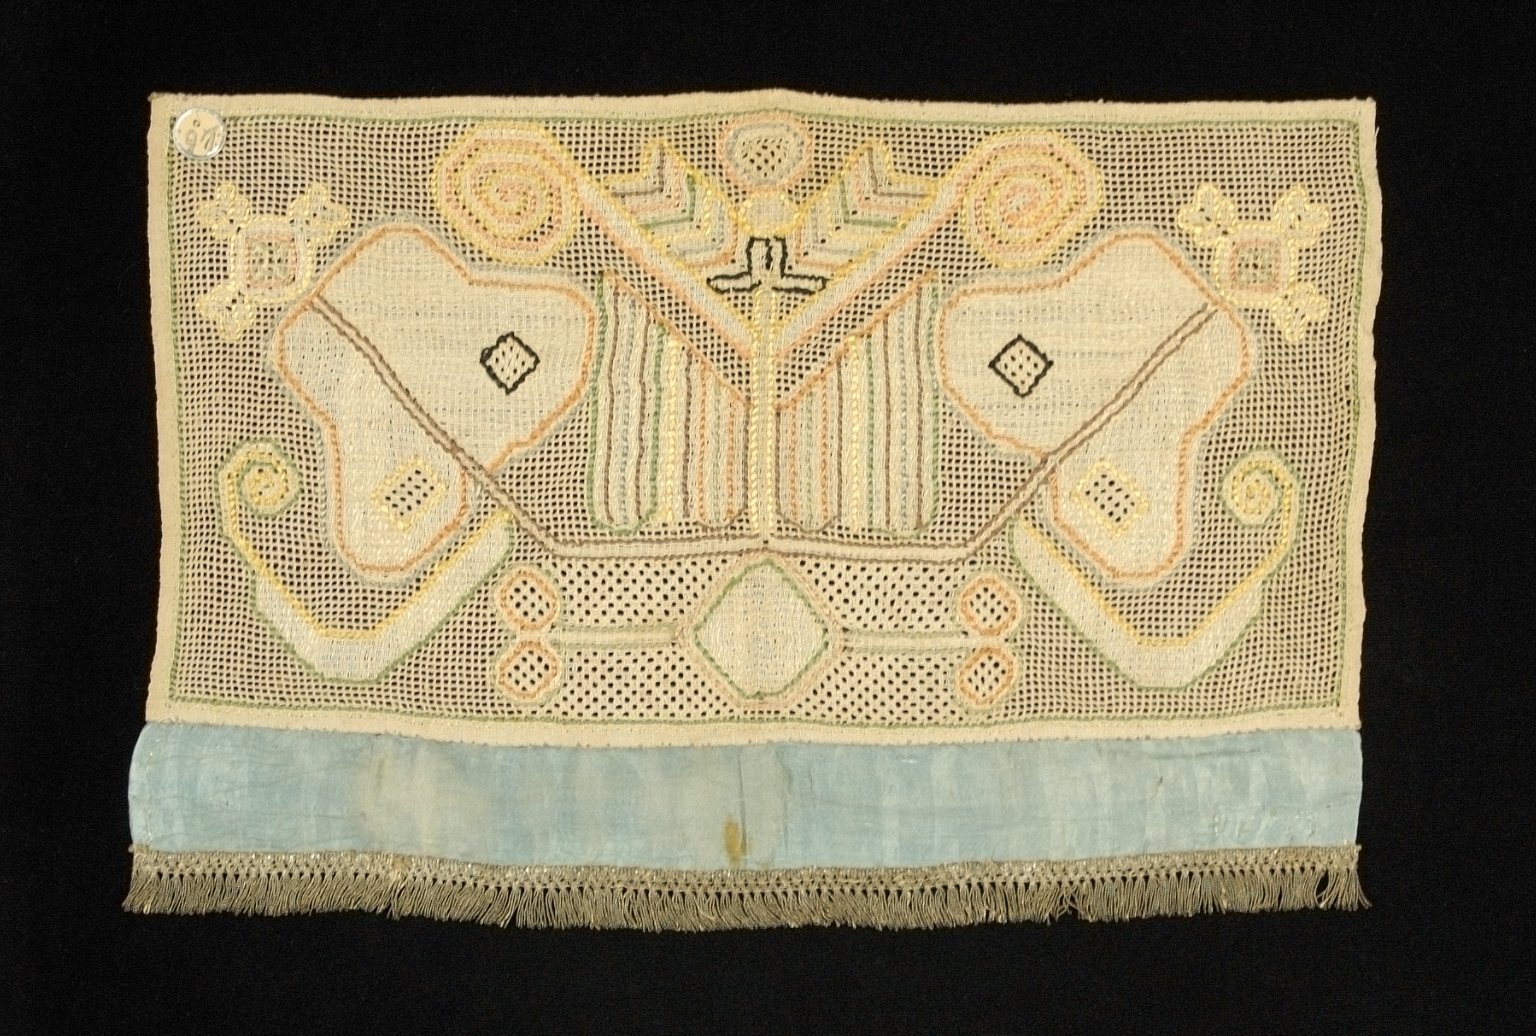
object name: border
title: Towel border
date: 1800-1850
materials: linen, silk